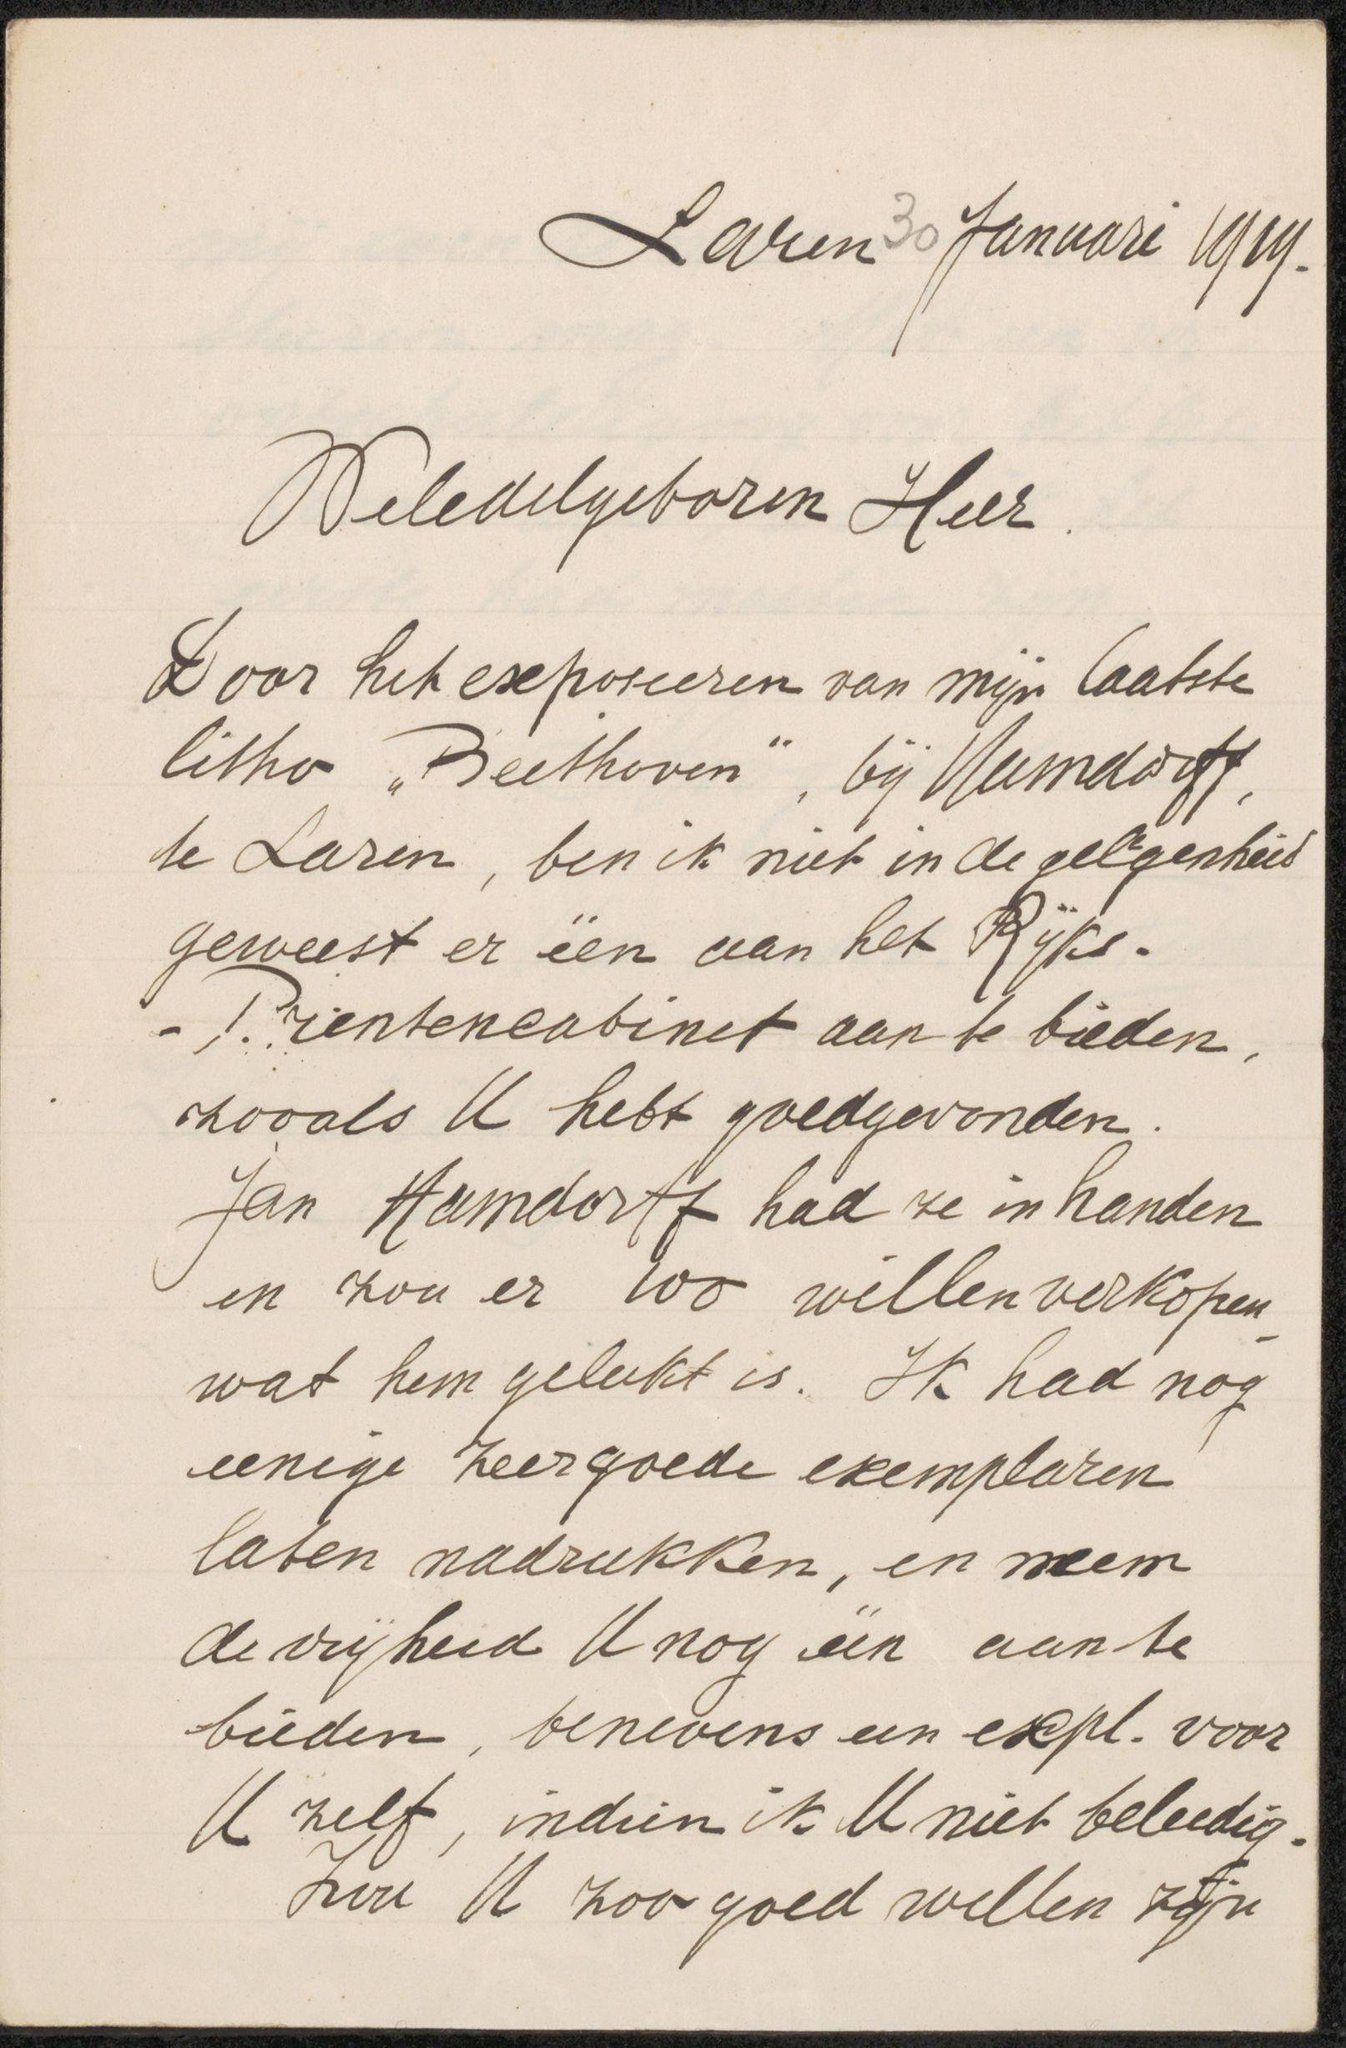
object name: letter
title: Brief aan jonkheer Hendrik Teding van Berkhout (1879-1969)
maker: jan fekkes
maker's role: draughtsman, print maker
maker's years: 1885-1933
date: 1901-1919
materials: ink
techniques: pen, writing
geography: laren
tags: haarlem, amsterdam, jonkheer hendrik teding van berkhout (1879-1969), the graphic arts, exhibition ~ art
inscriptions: collector's mark: ‘RPK’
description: De prent onder gerelateerd object wordt genoemd in de brief.